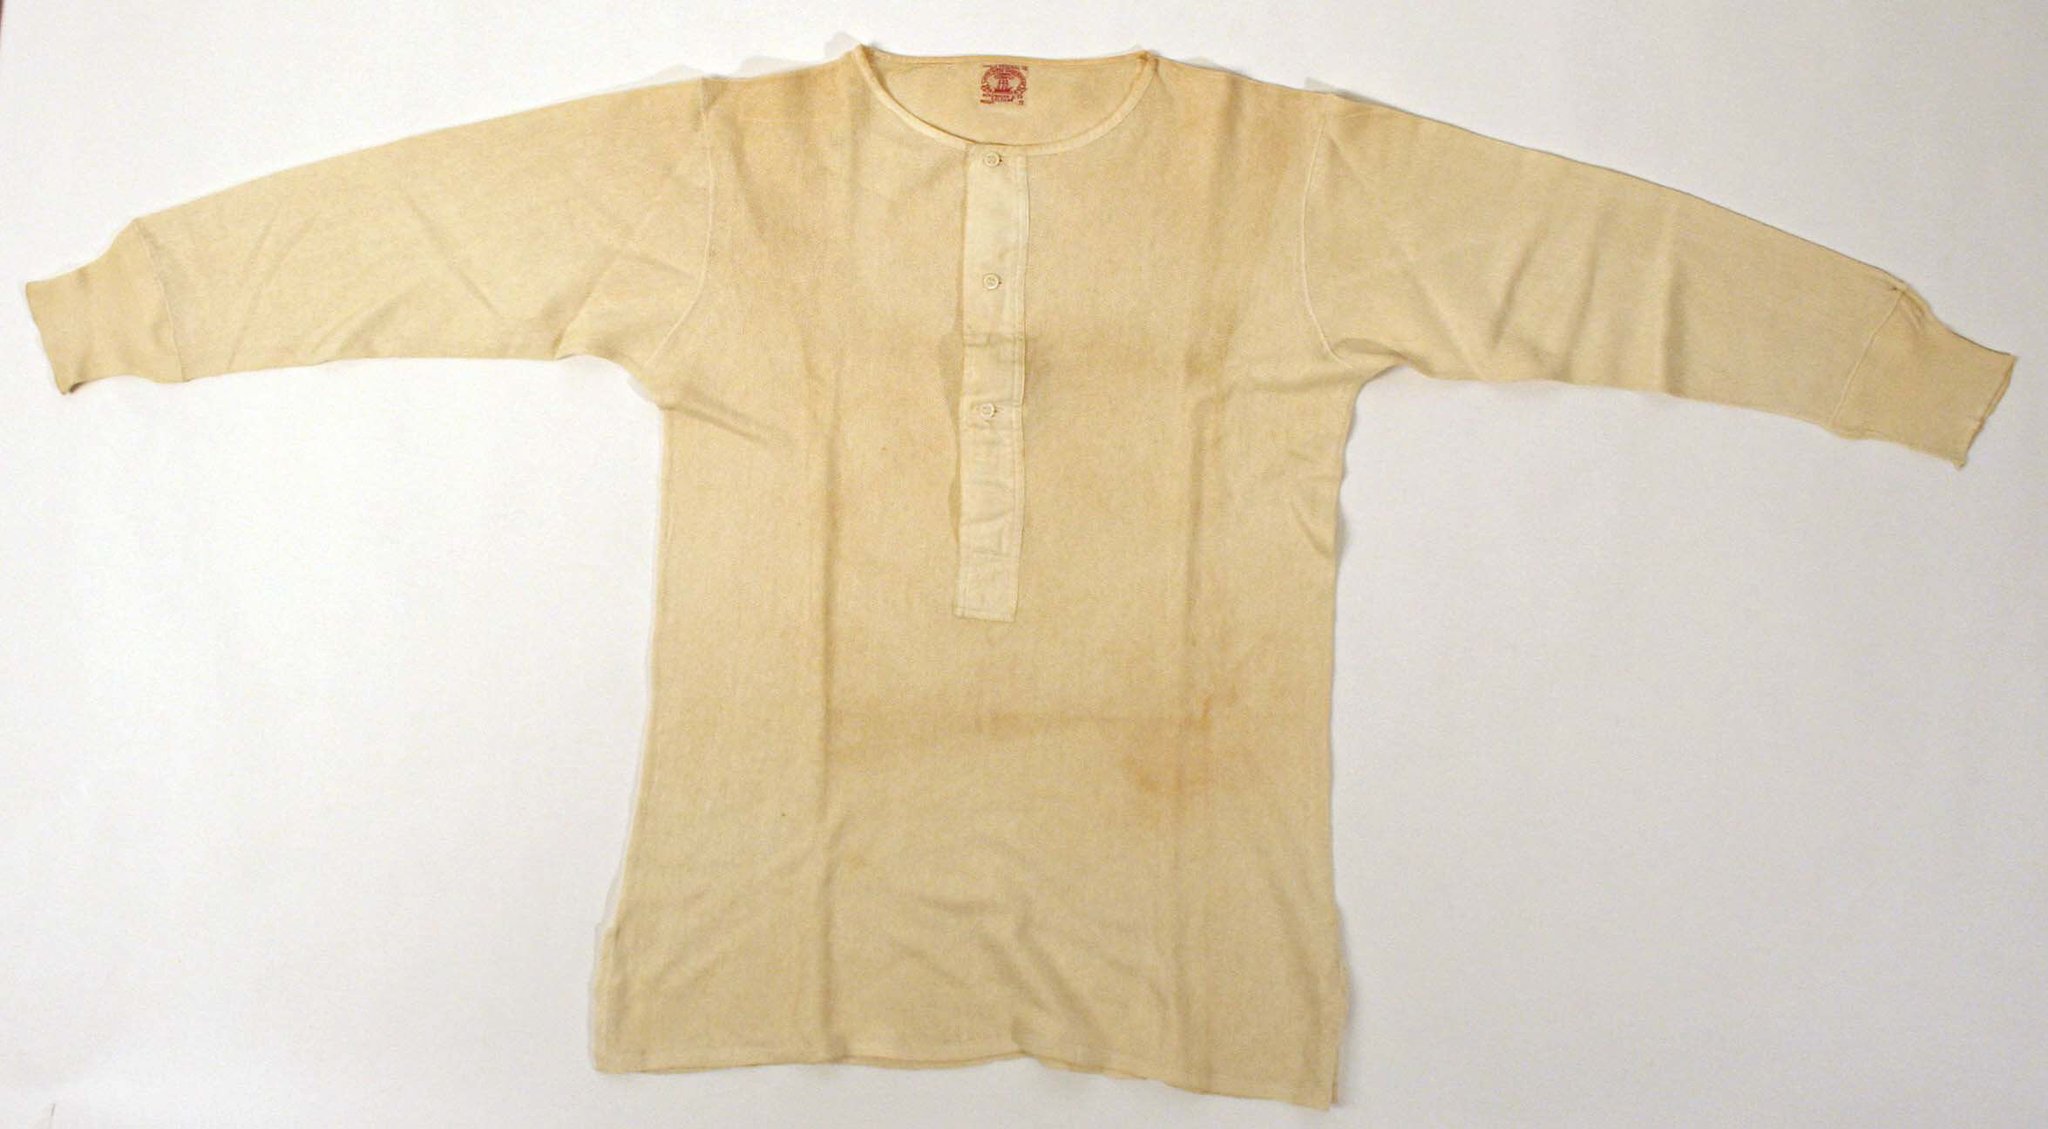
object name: underwear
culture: german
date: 1900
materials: linen